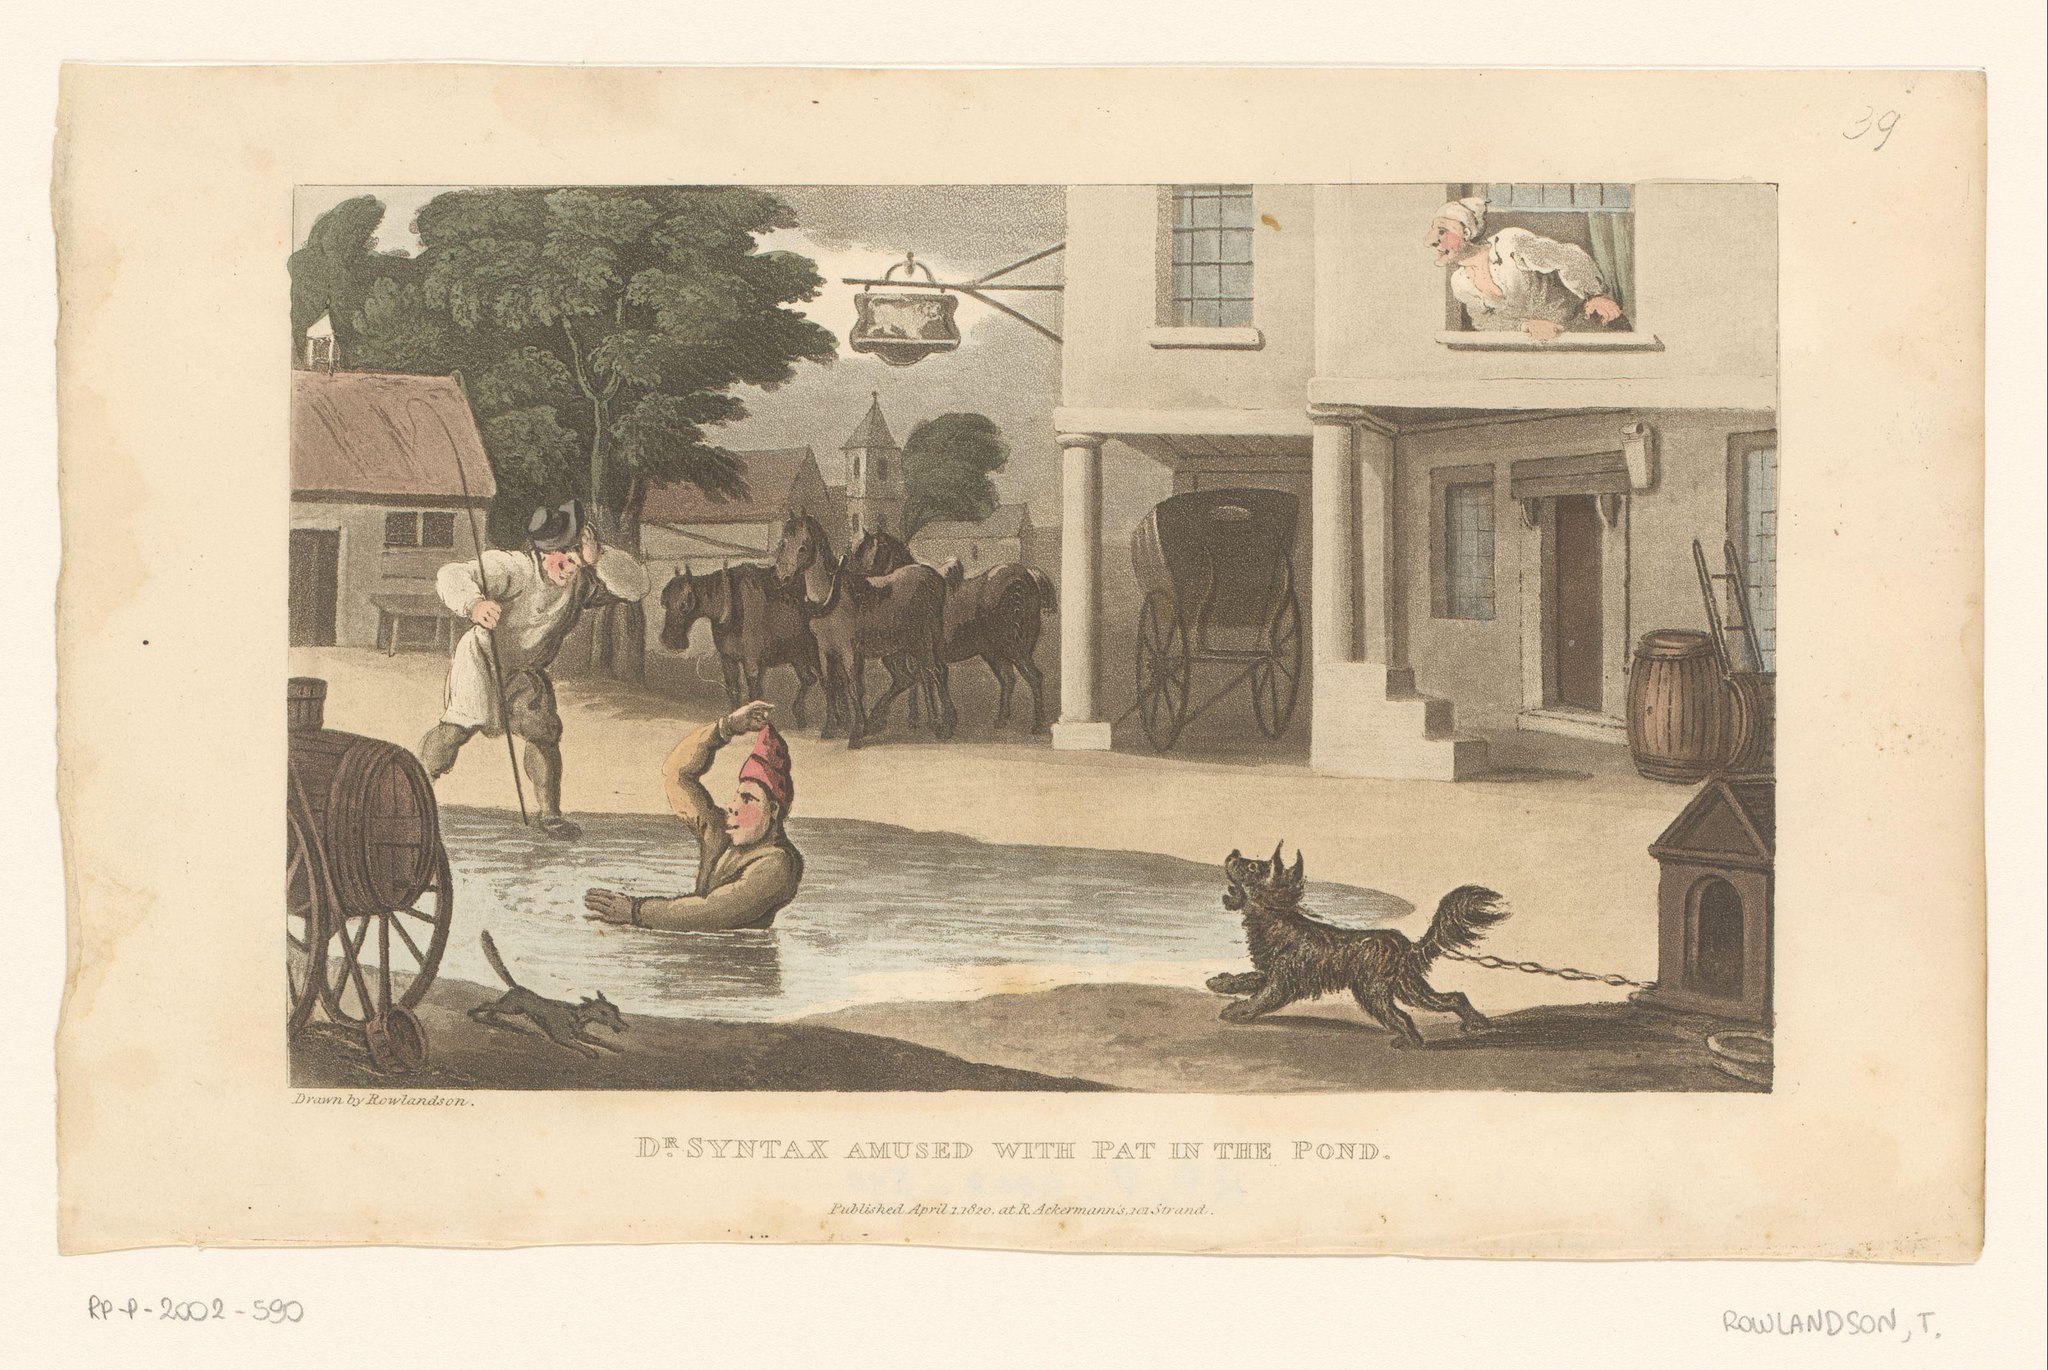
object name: cartoon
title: Dr. Syntax amused with Pat in the Pond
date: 1804-1820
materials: paper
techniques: aquatint, etching, hand coloring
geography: london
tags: laughing, human figure at (open) window, seen from outside, pond, pool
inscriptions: collector's mark: Lugt 2228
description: Prent ook gebruikt in: Combe, William. The second Tour of Doctor Syntax, in search of consolation; a Poem. Londen: Rudolph Ackermann, 1820.